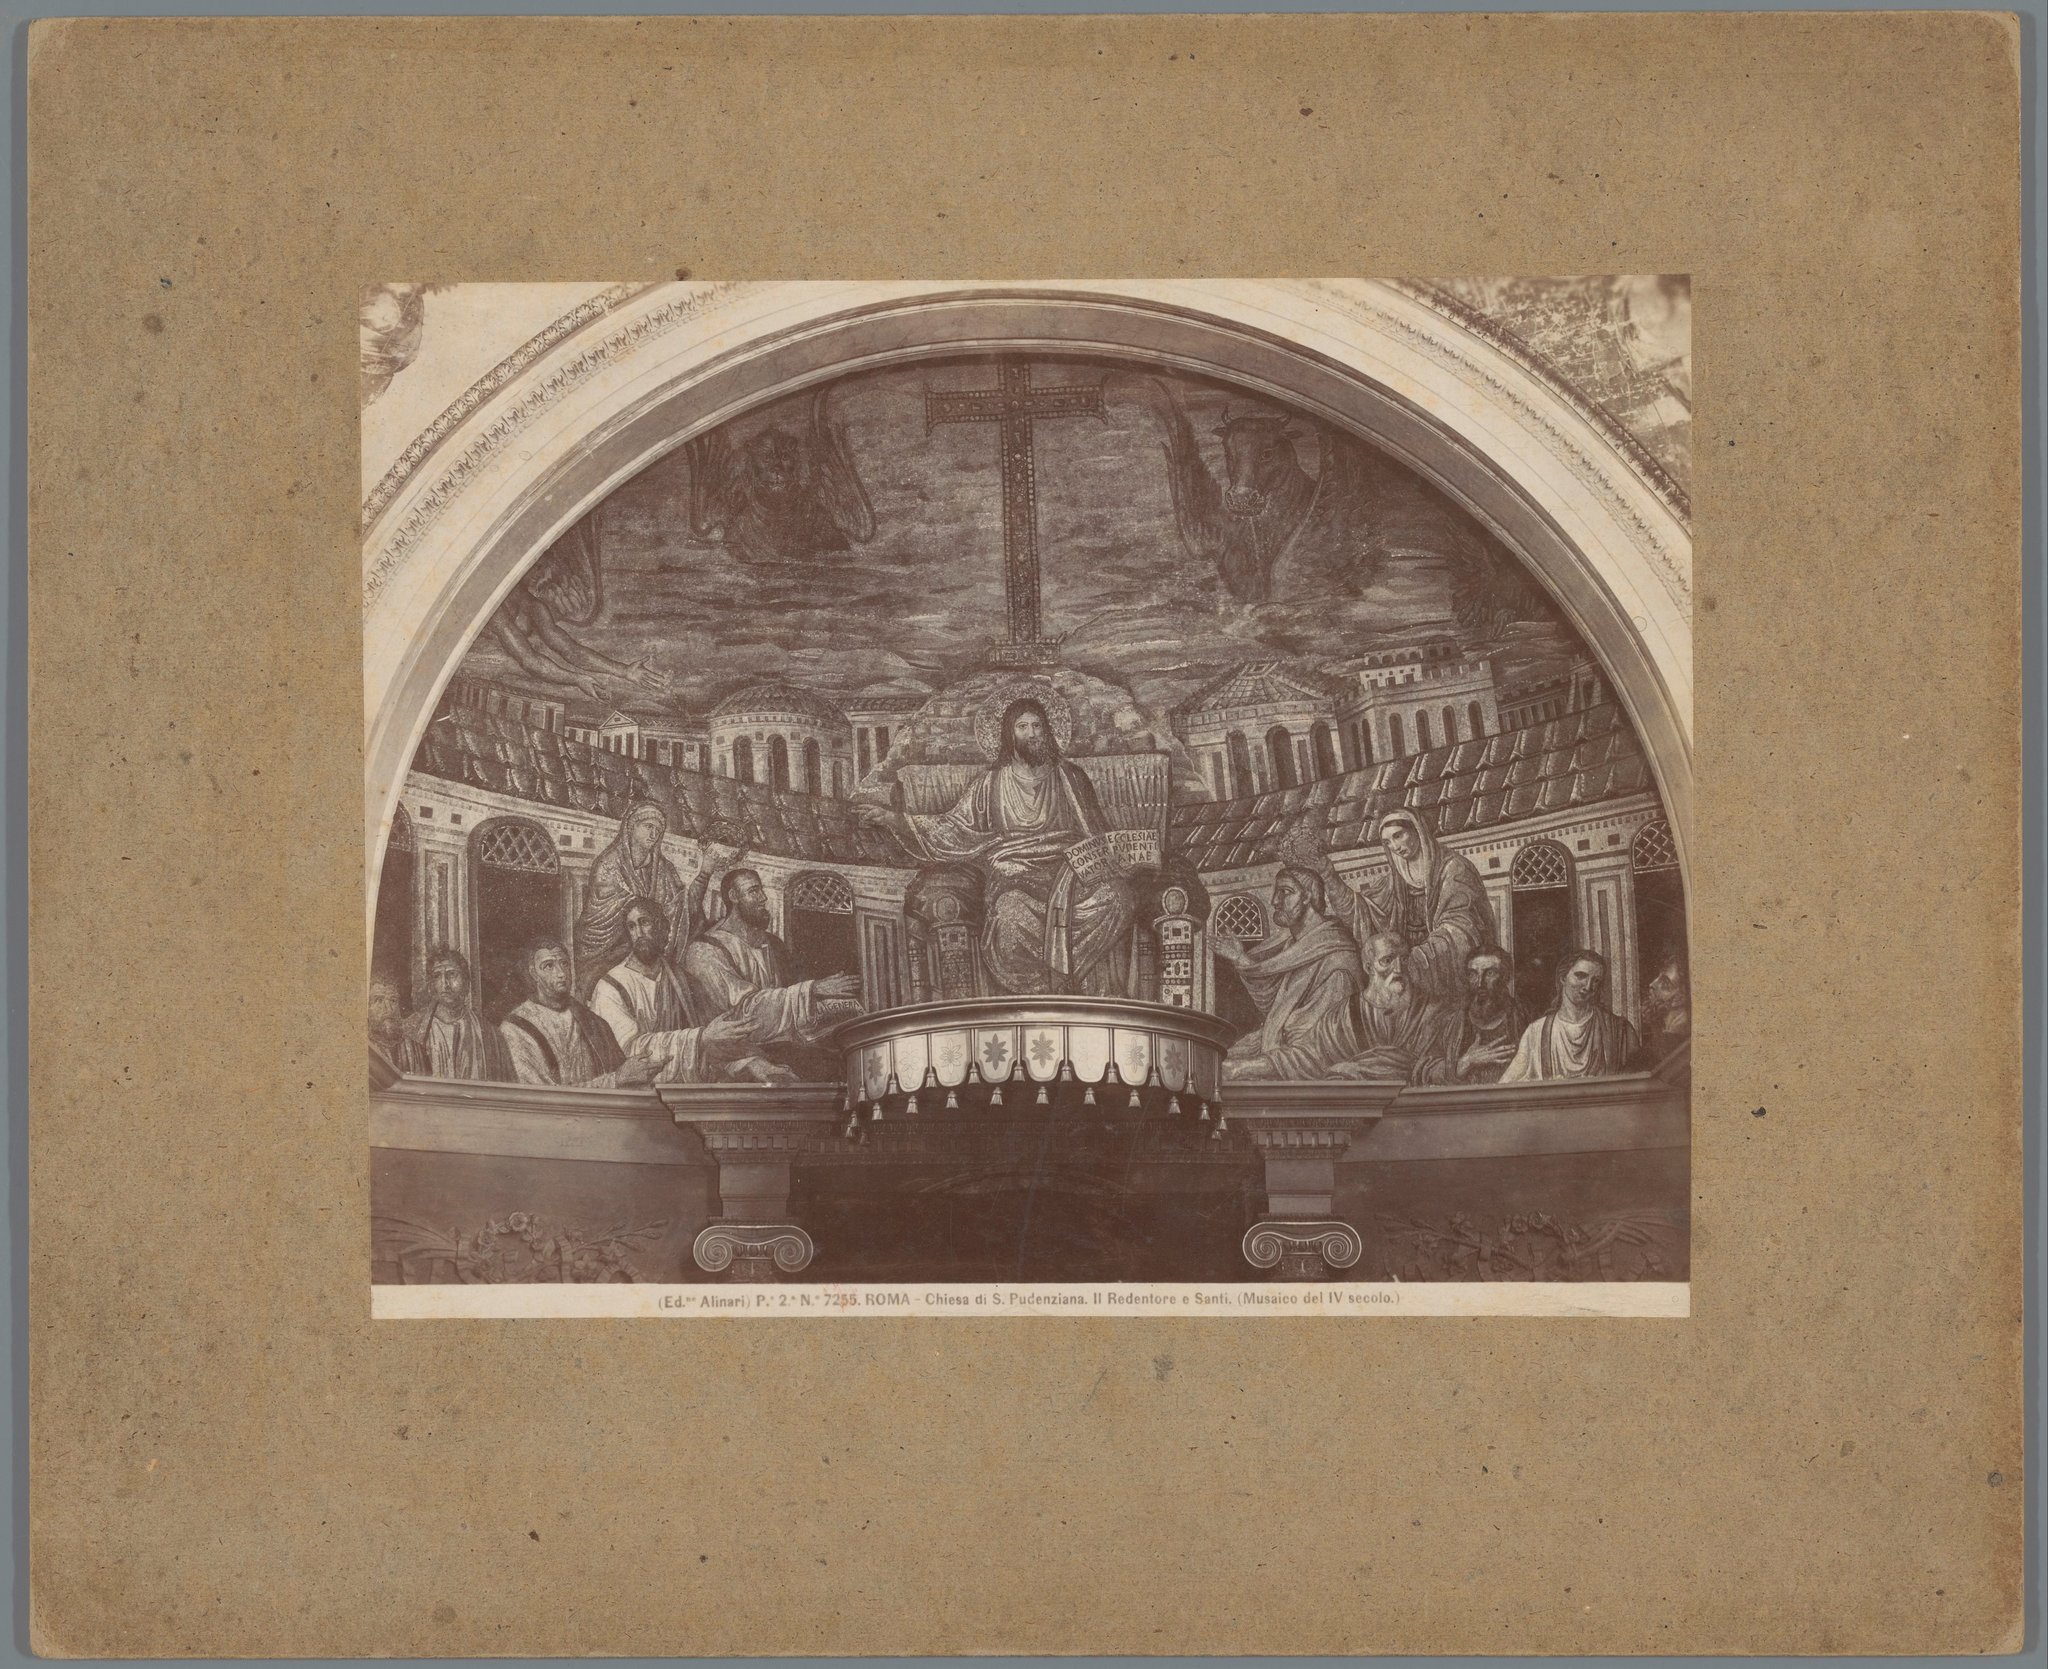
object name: photograph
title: ROMA - Chiesa di S. Pudenziana. Il Redentore e Santi.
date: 1875-1900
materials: cardboard, photographic support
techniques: albumen print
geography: santa pudenziana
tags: art (+ mosaic making), saints, christ, interior of church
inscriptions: collector's mark: Lugt 3937, number: ‘P.e 2.a N.o 7255.’